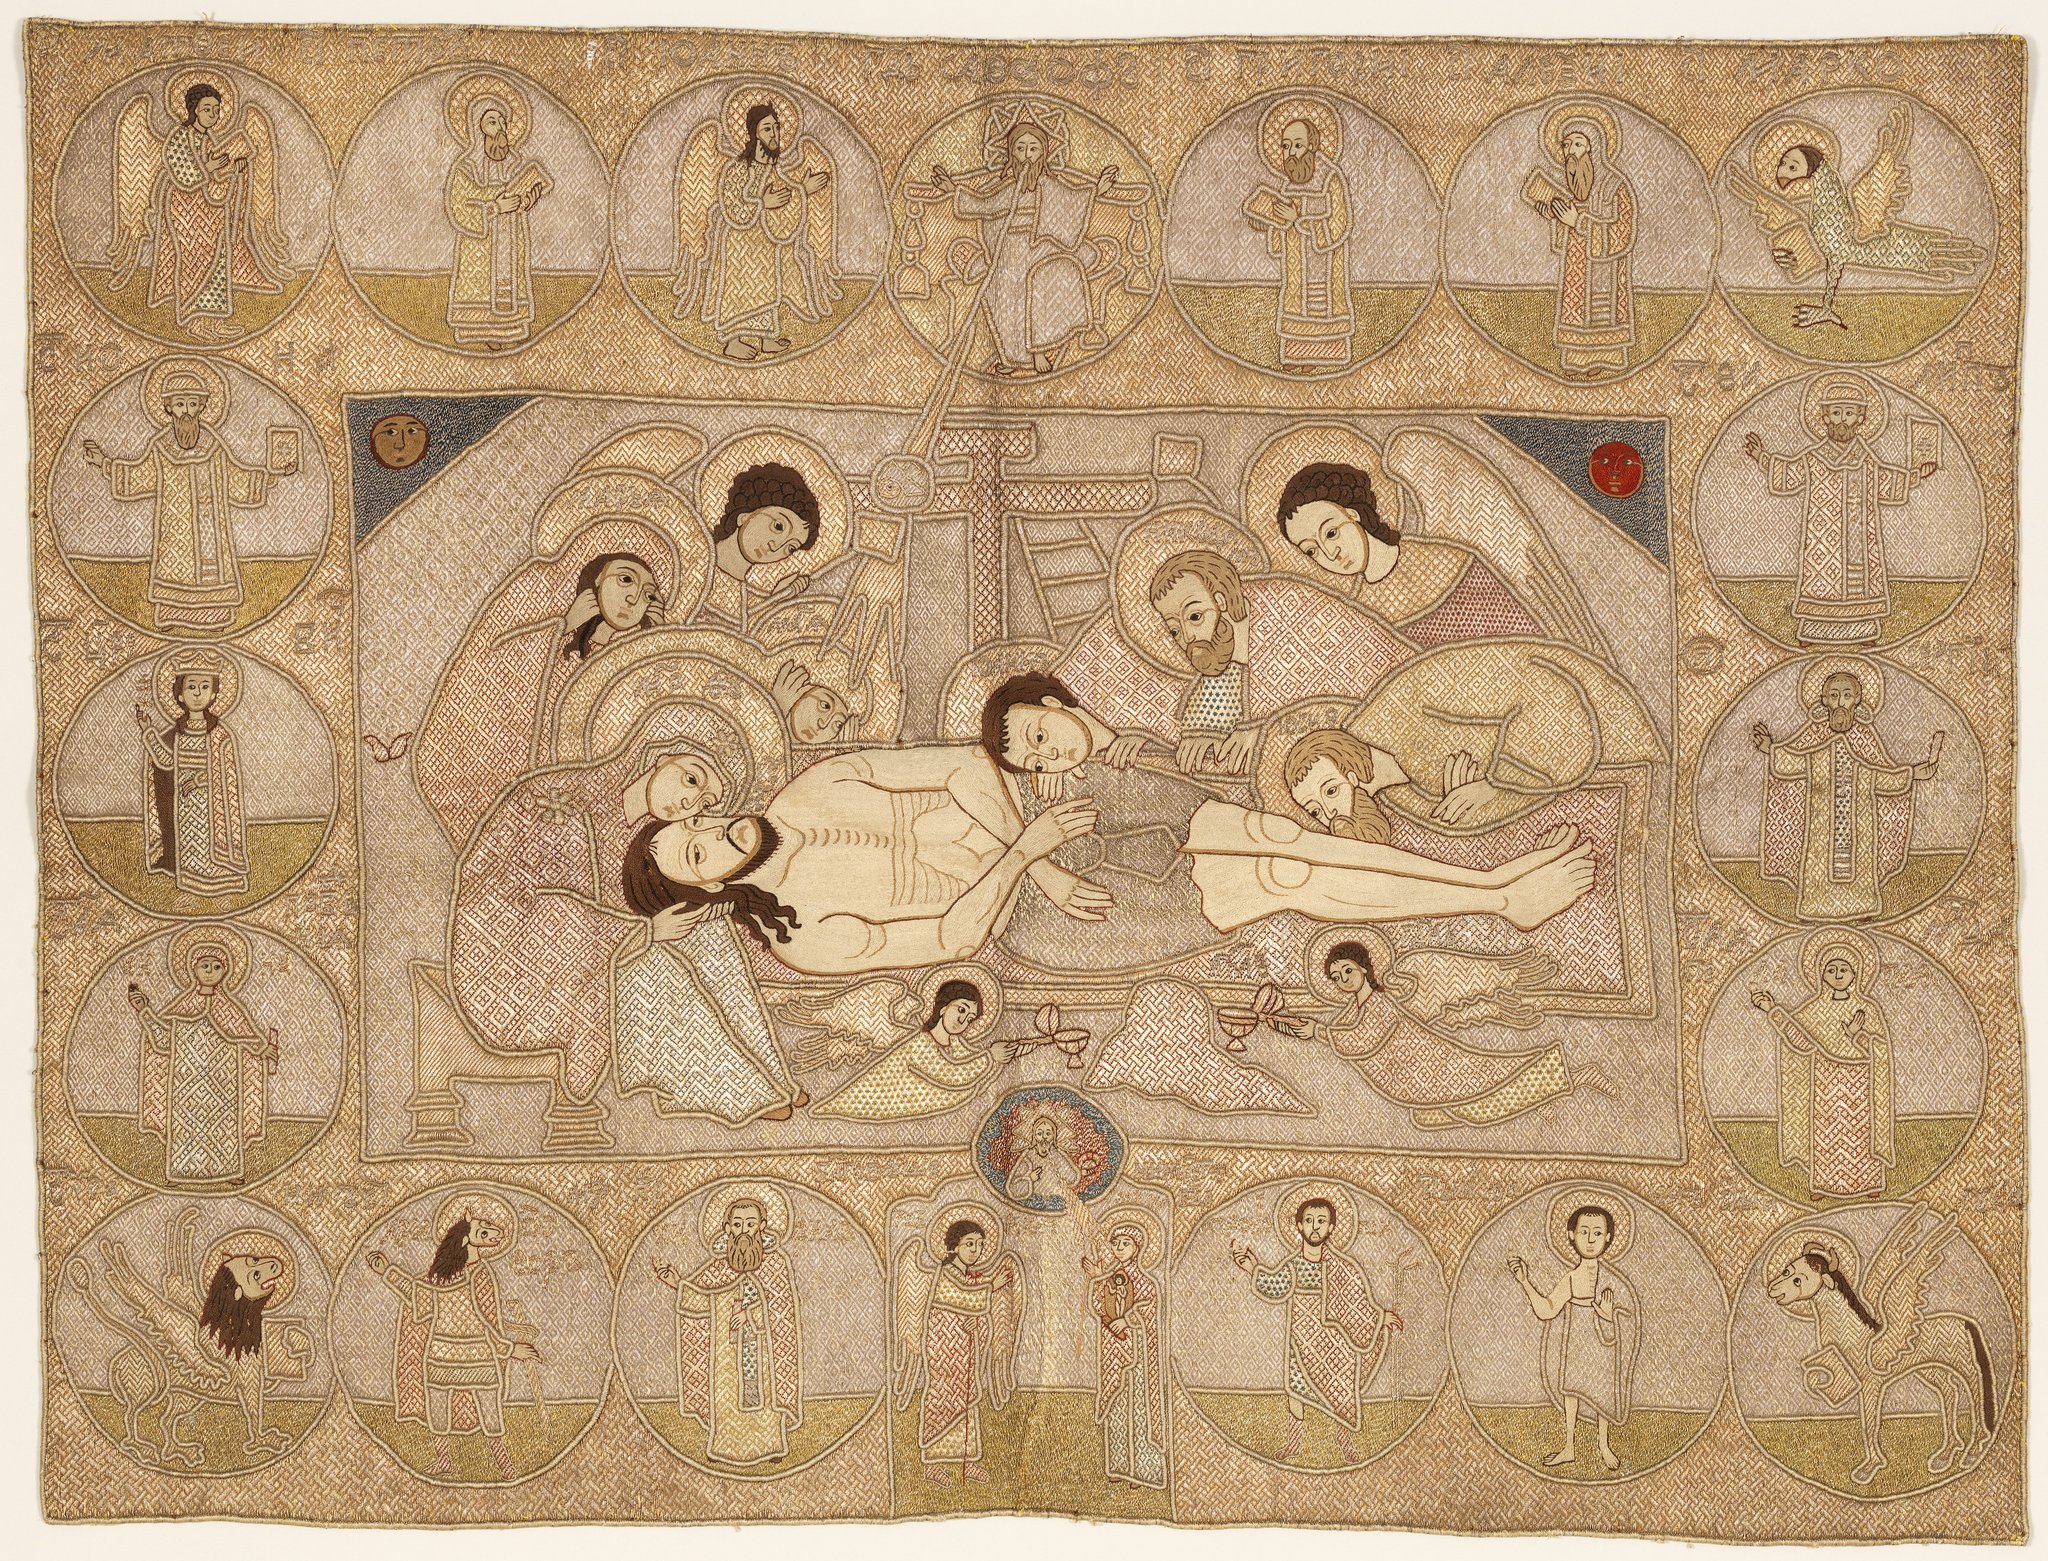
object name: epitaphios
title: Epitaphios (Plashchanitsa)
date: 1651-1675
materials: linen, metal thread, silk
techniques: embroidery, weave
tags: pegasus,angels,christ,lamentation,saints